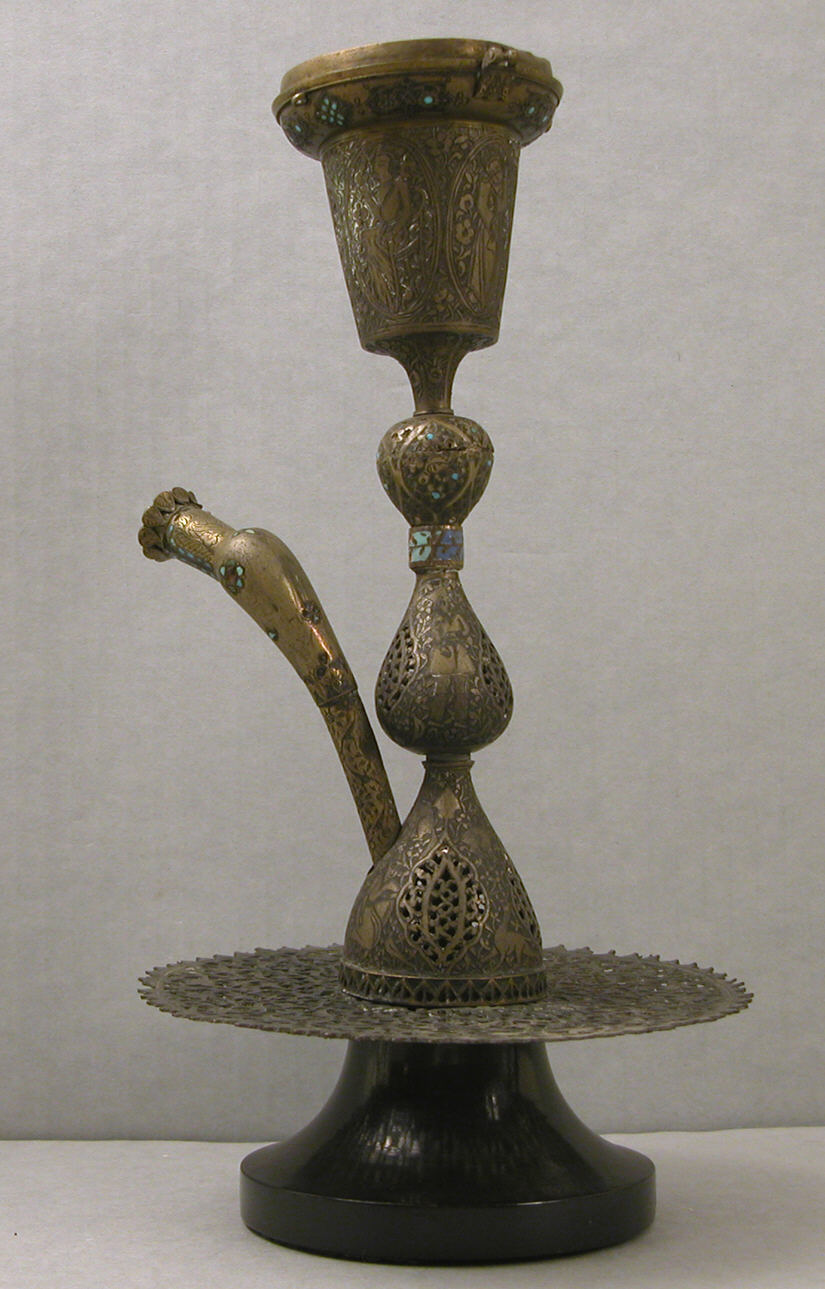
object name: water pipe top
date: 1701-1800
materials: brass, enamel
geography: iran